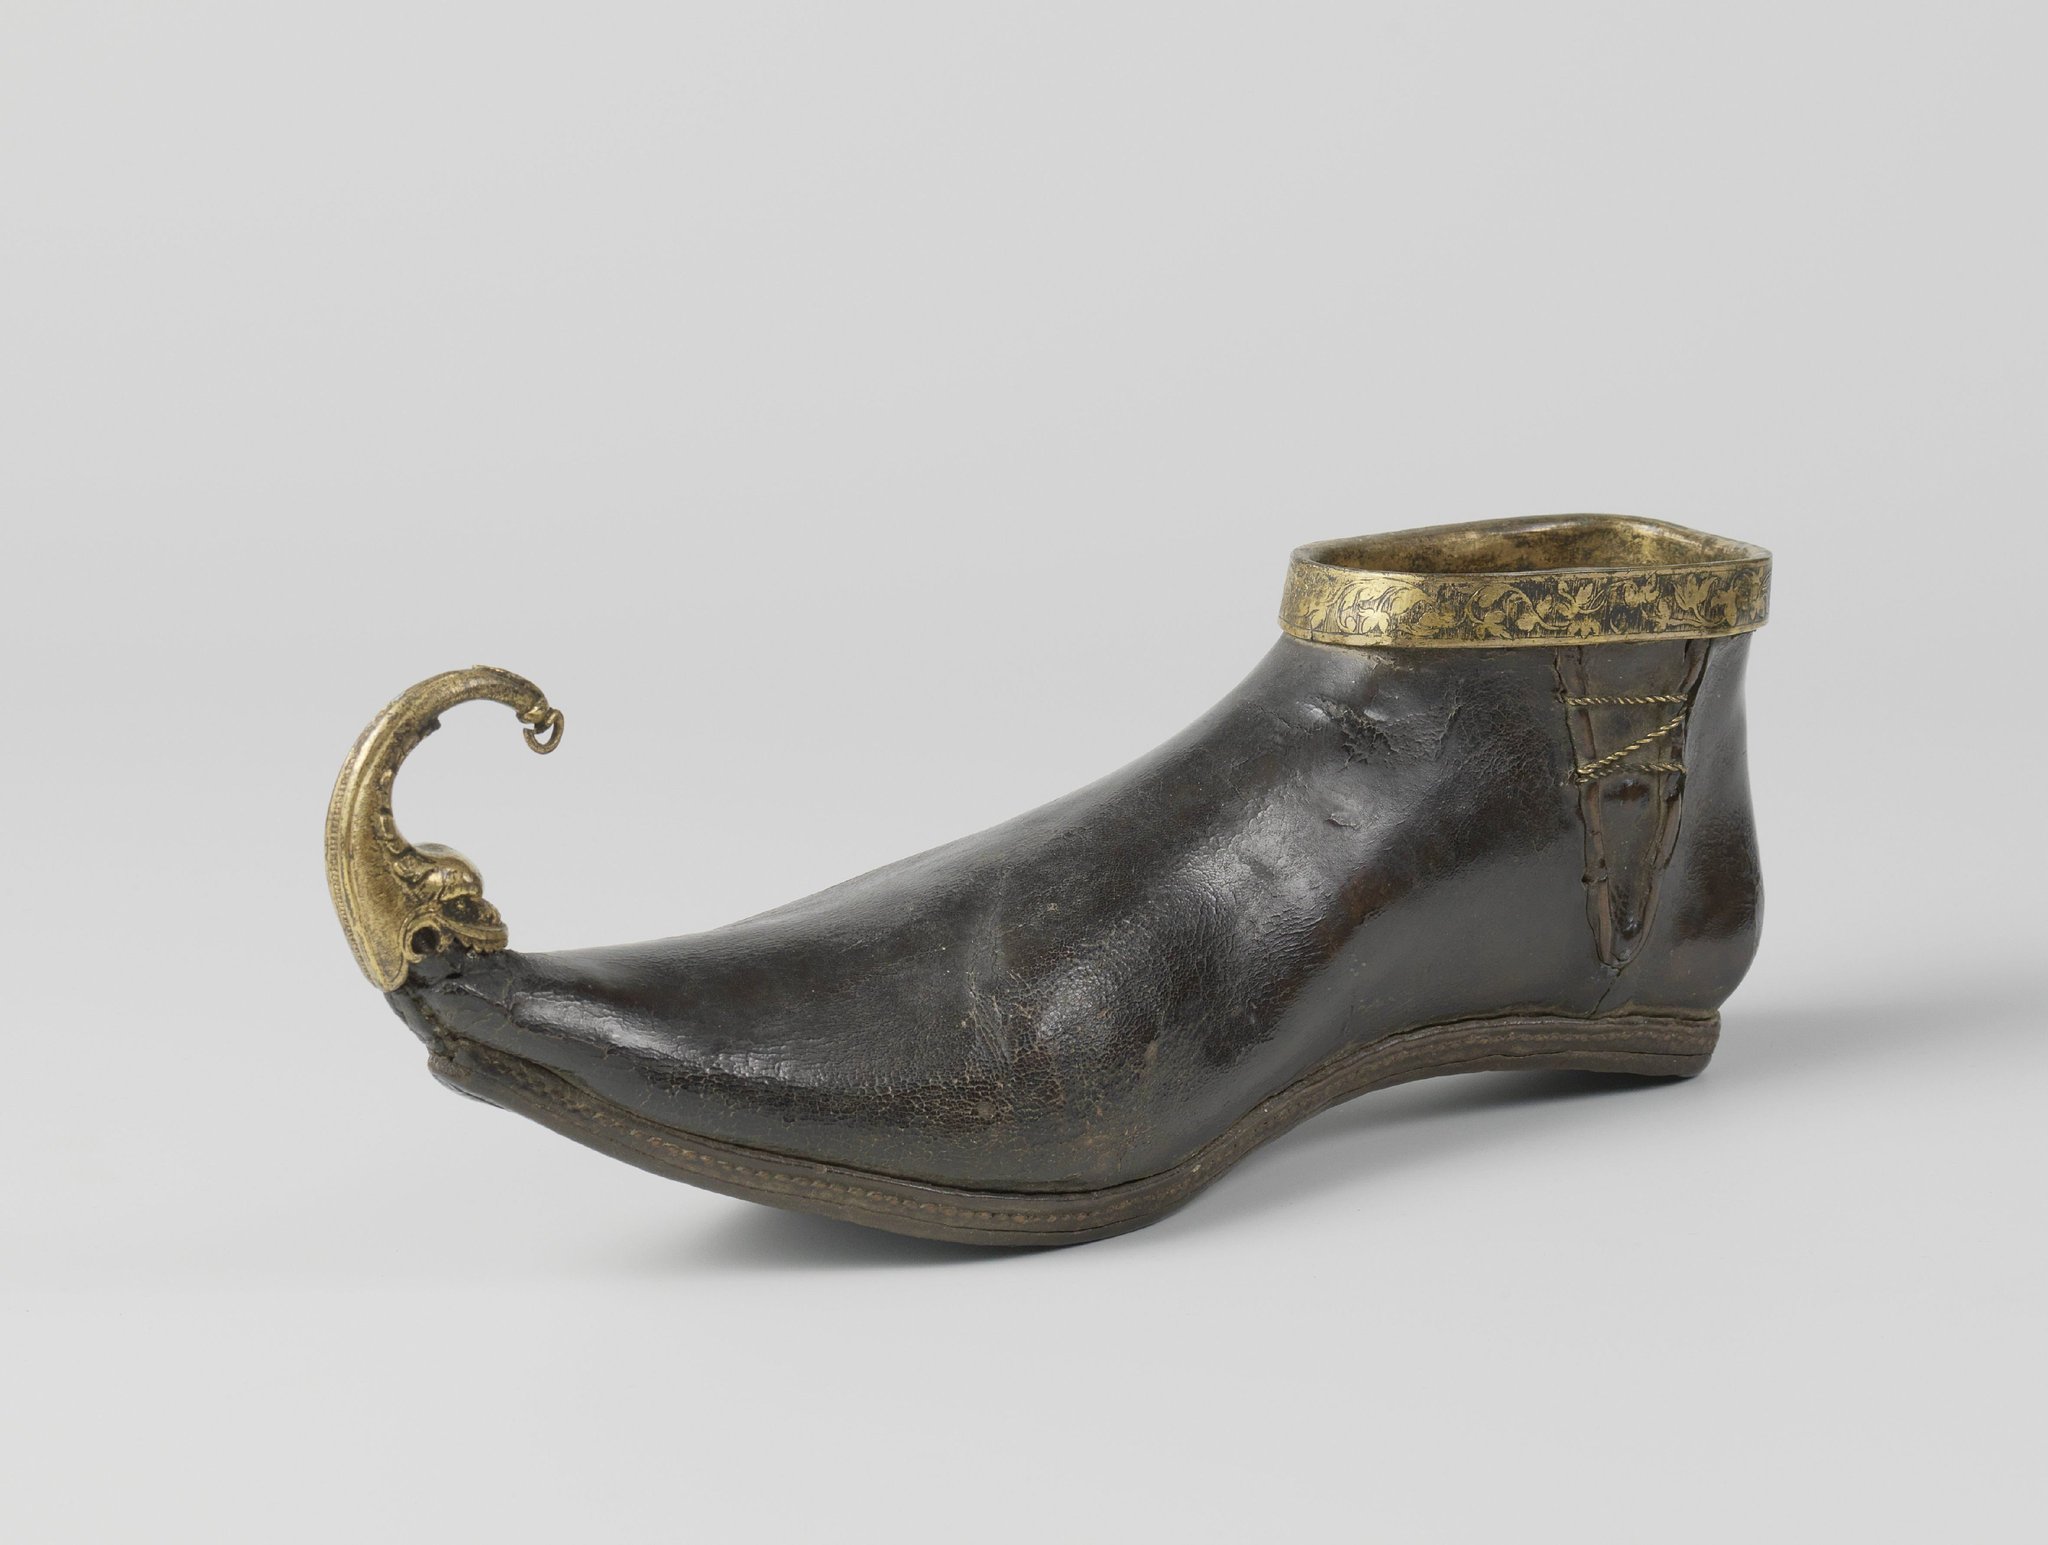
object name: crakow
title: Étui or wager (‘drink-up’) cup in the shape of a shoe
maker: Anonymous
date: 1400-1450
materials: copper, leather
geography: france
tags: dolphin ~ ornament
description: Lederen poulaine schoen. Aan de punt een verguld koperen(?) dolfijn. Aan de enkel een vergulde gegraveerde rand, 16e eeuw. Schijnt een doos geweest te zij. (Gildeproef) Op een papier: Polade schoe der Edelieden ten tijde van Philips, Hertog van Bourgogne. Uit het Kabinet van Joh. Fredericus Gronovius.'